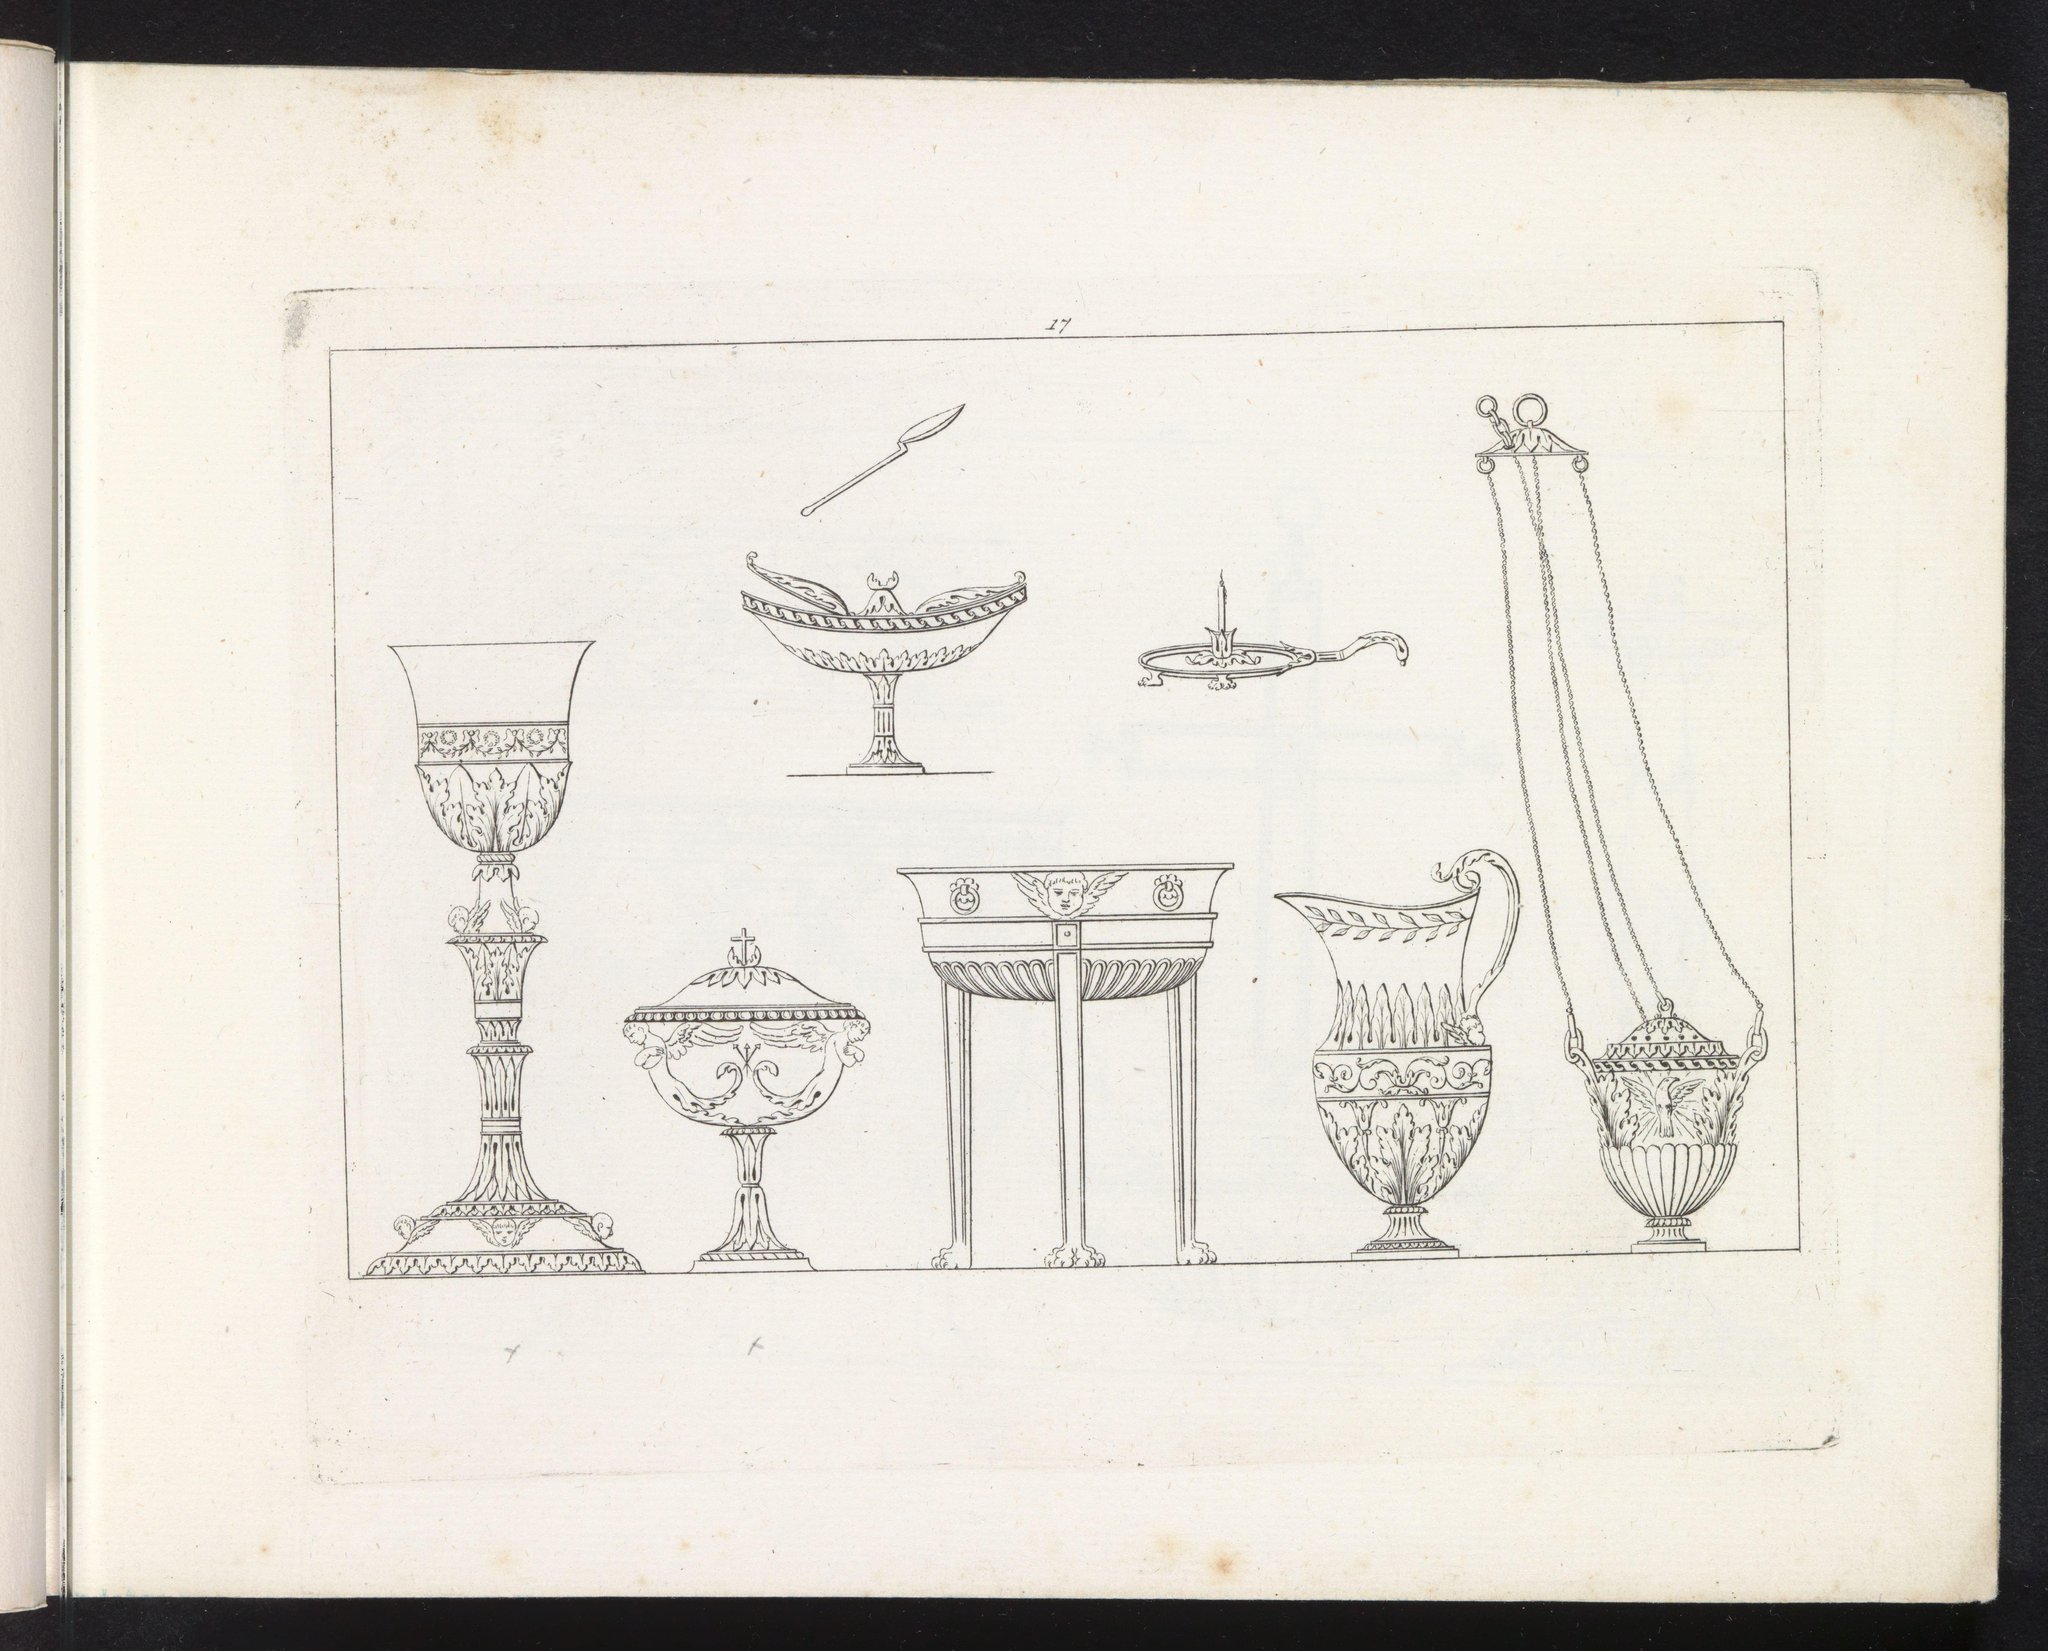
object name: ornament print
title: Ontwerpen voor religieuze en profane voorwerpen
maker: pietro ruga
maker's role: print maker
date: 1817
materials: paper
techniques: etching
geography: italy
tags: ornaments ~ art, chandelier, candelabrum, censer, pots, jars: chalice (calice), jar, jug (used as drinking-vessel), serpent ouroboros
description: Prent maakt deel uit van een reeks van 100 prenten (+ titelprent) met ontwerpen voor religieuze en profane voorwerpen.